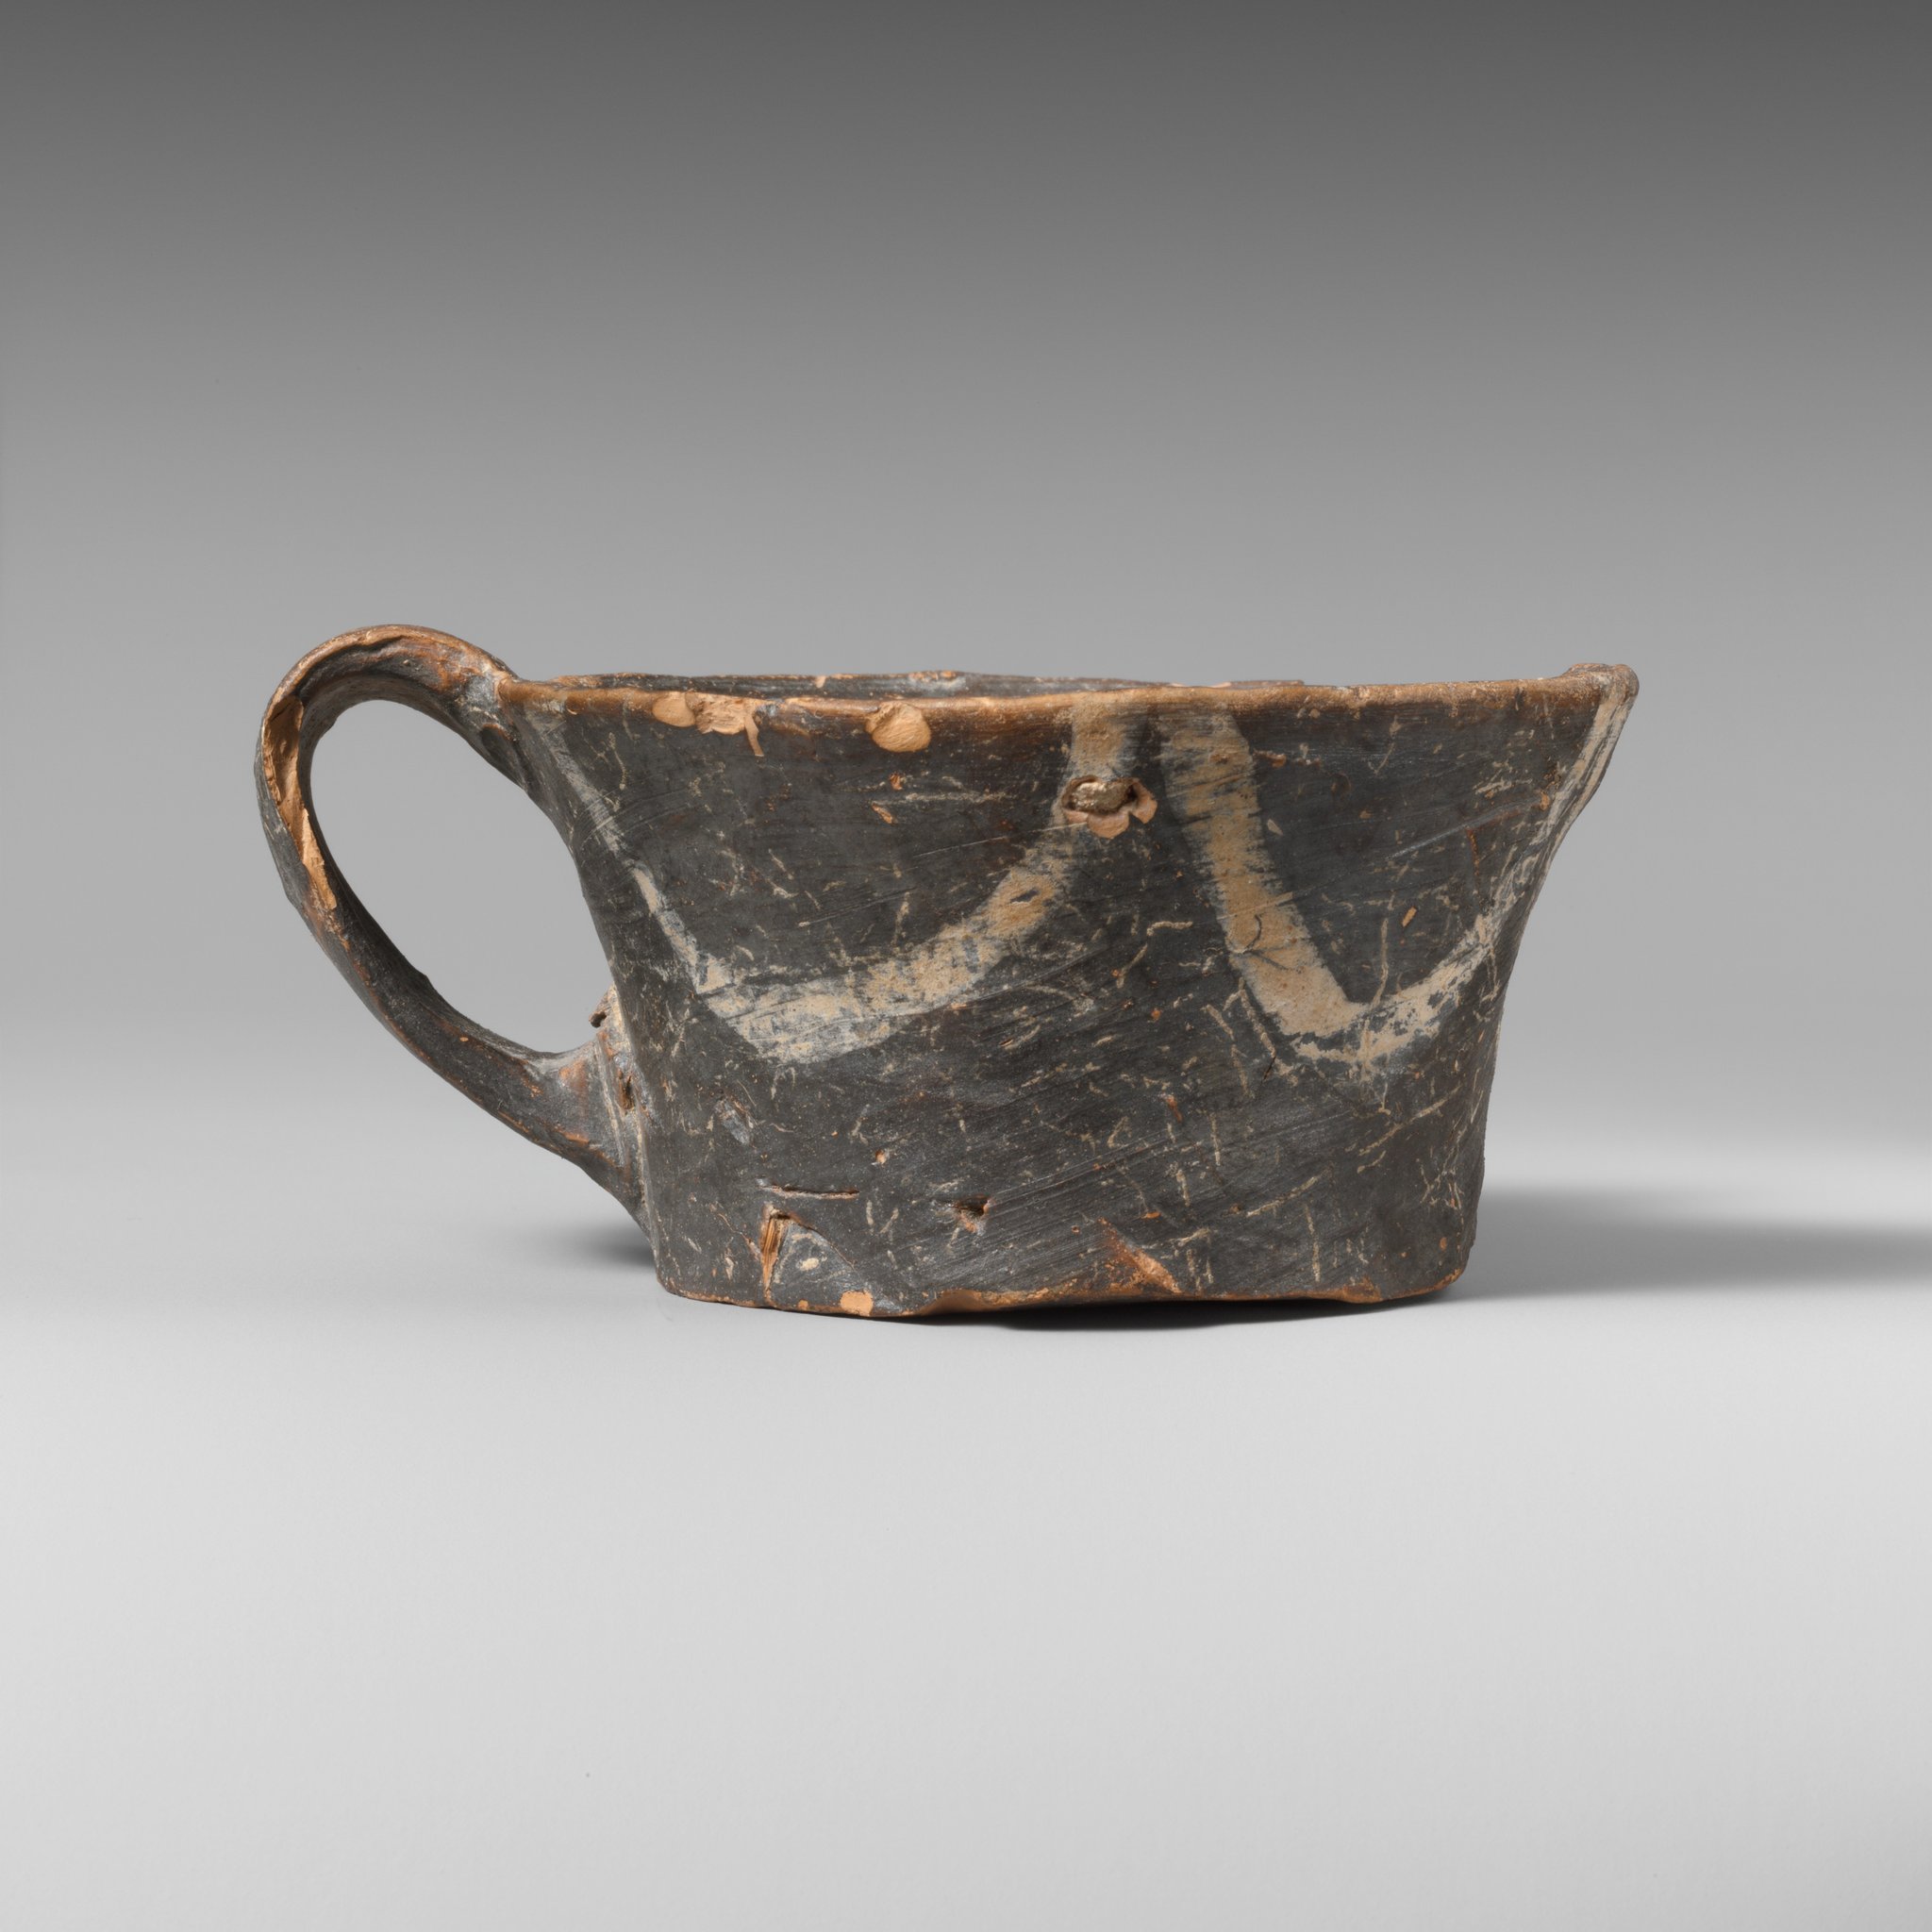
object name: cup, one handled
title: Terracotta straight-sided cup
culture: minoan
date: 1950-1900 BCE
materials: terracotta